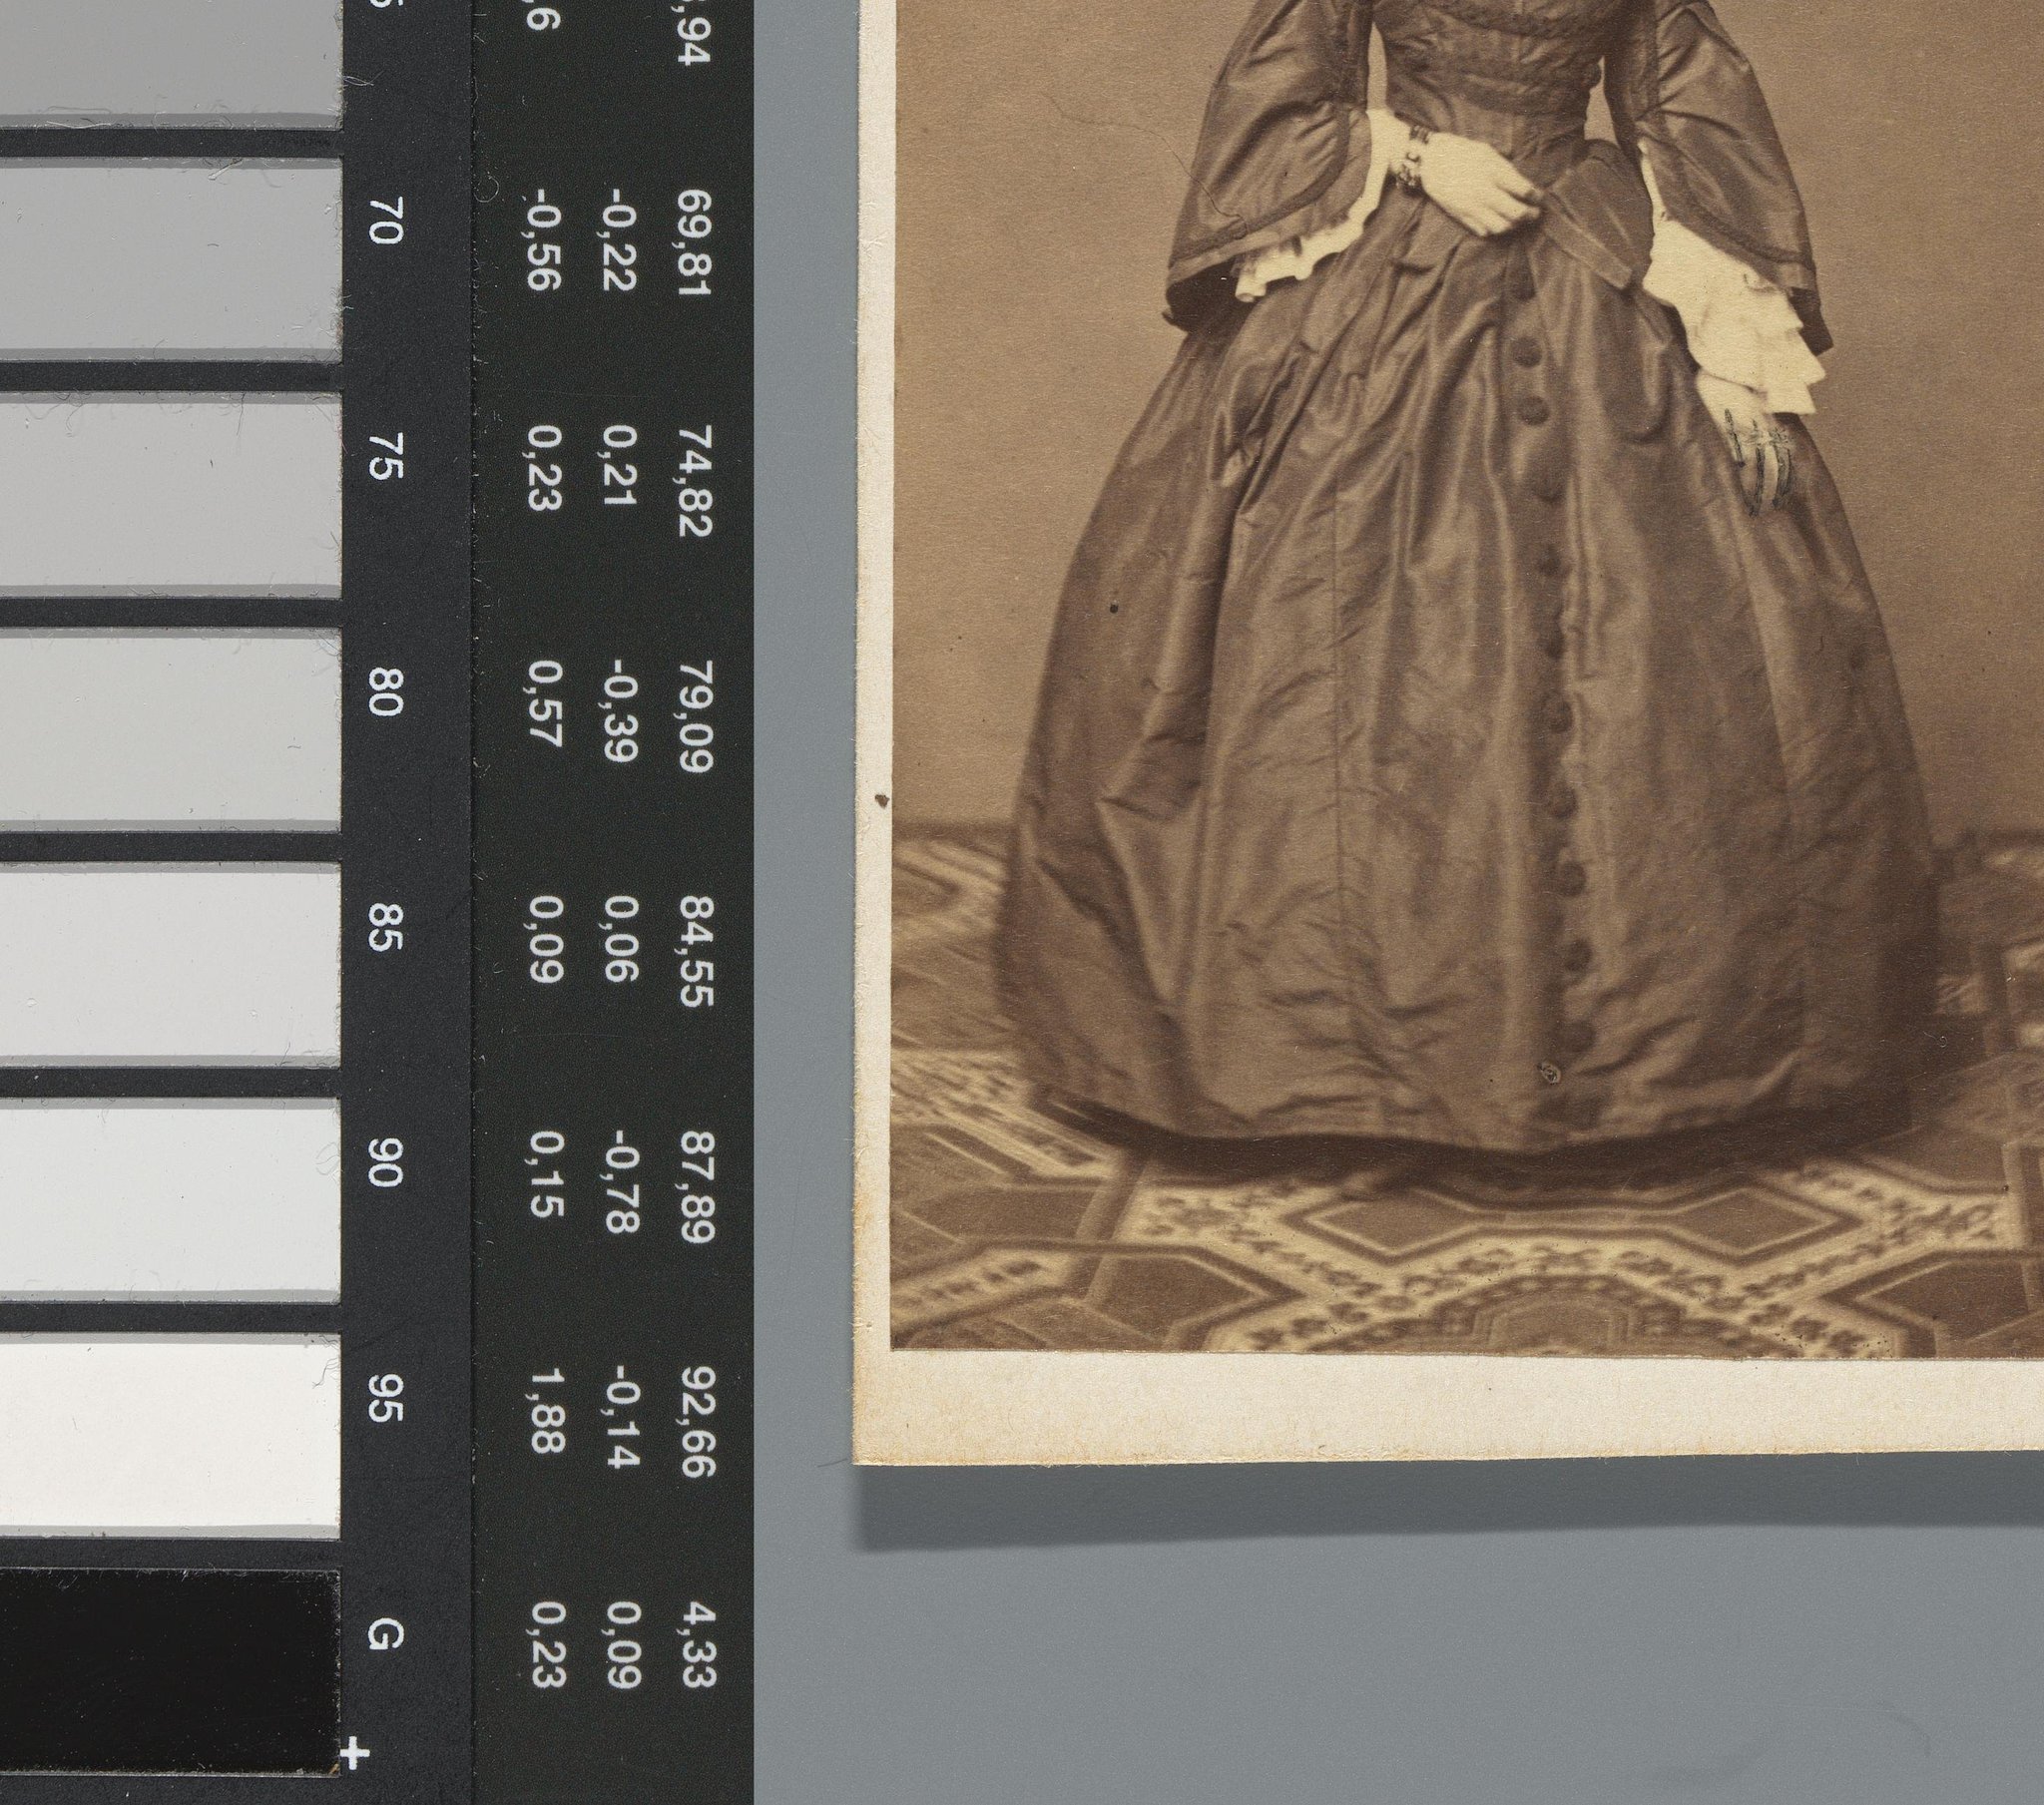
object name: photograph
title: Portret van tante Jans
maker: gerrit hoogwinkel jr.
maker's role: fotograaf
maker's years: 1837-1890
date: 1855-1910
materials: cardboard, photographic support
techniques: albumen print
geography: rotterdam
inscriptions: name: ‘oud tante / Jans van den / Berg’